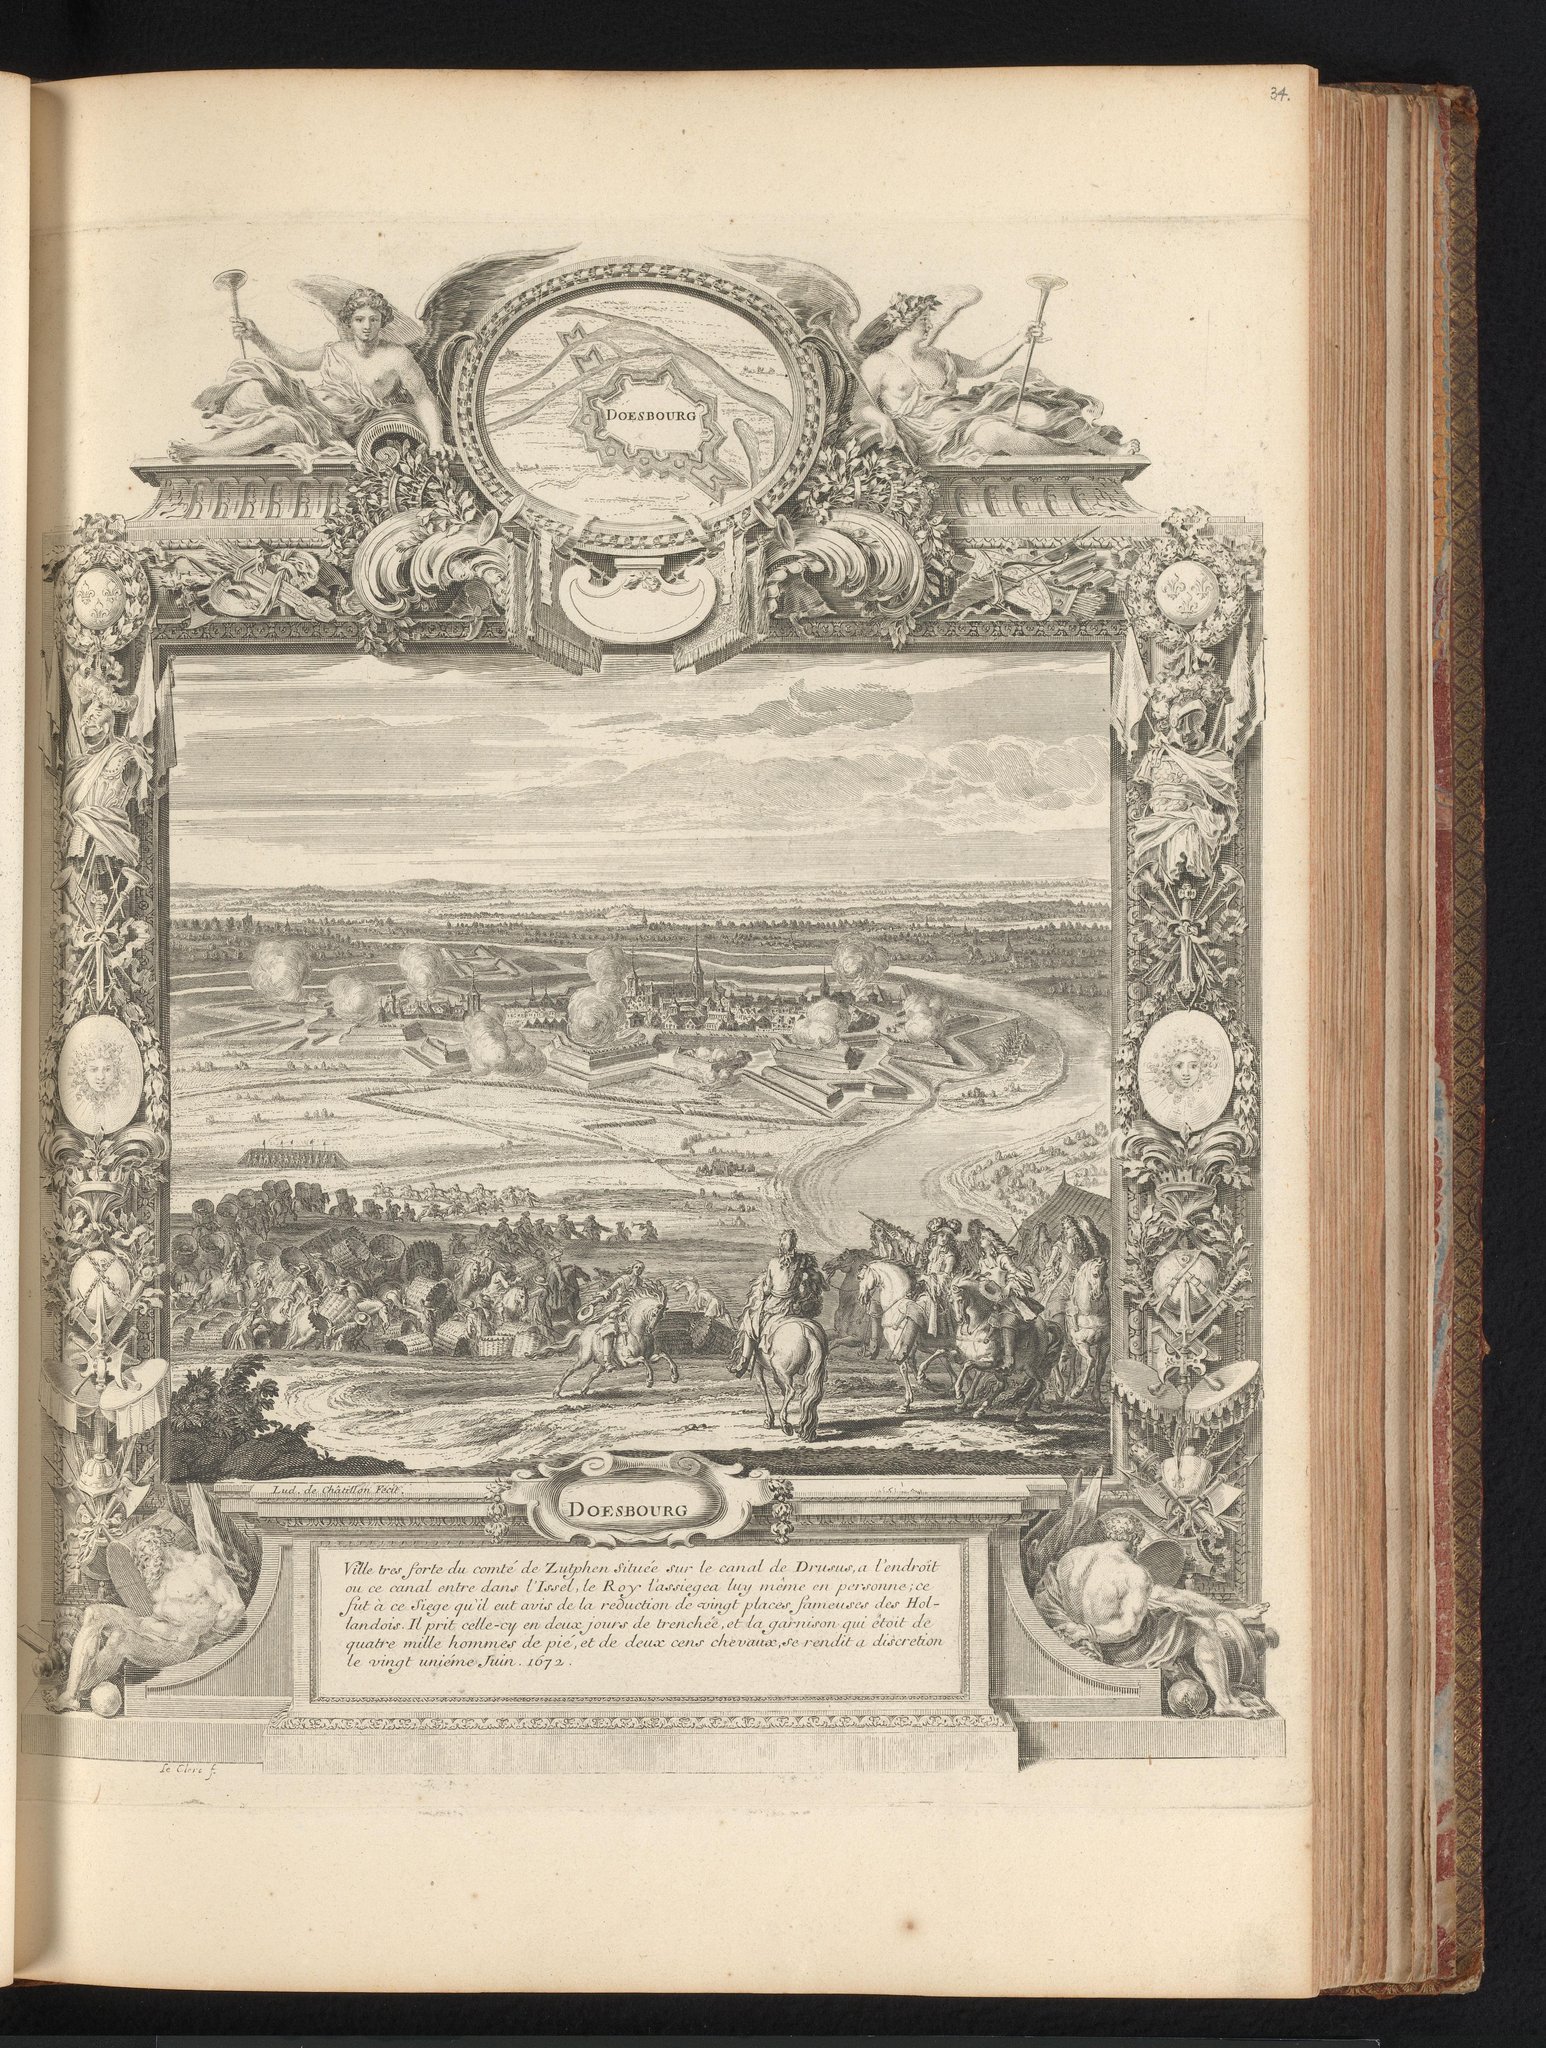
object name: print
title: Grandes conquêtes du Roi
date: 1686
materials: paper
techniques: engraving, etching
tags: battle, capture of city (after the siege)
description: Maakt deel uit van een serie bestaande uit 28 prenten met oorlogstaferelen in ornamentele cartouches. De prenten zijn gedrukt van twee afzonderlijke platen bestaande uit de voorstelling en de cartouche.